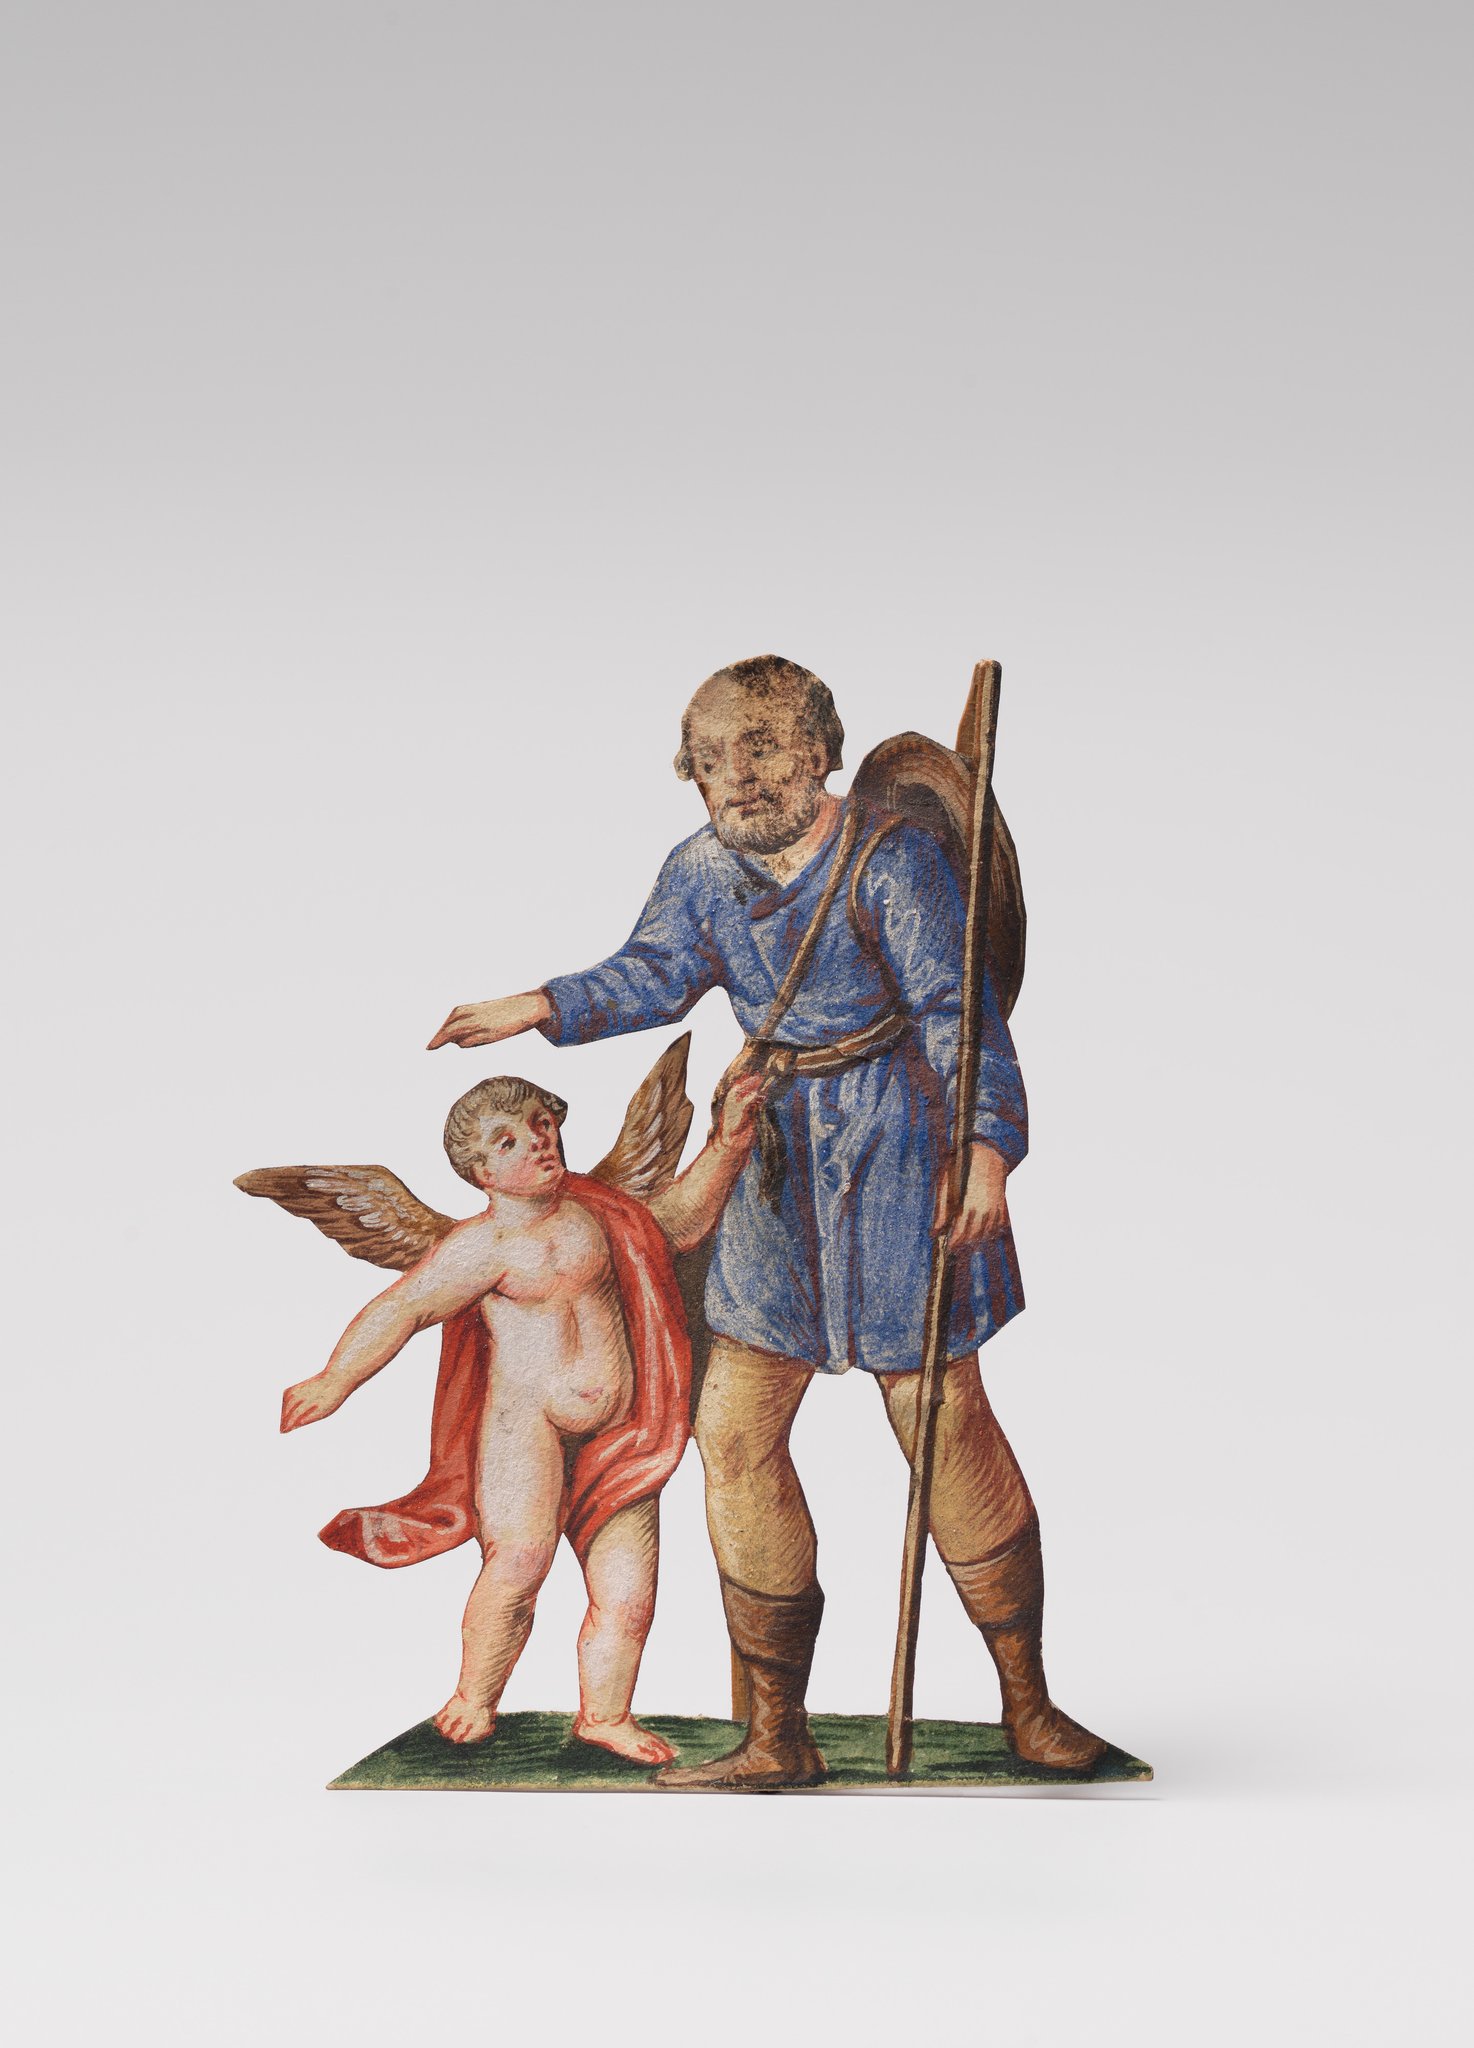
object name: figure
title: Cherub with shepherd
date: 1701-1800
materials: gouache, paper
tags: men,angels,nativity